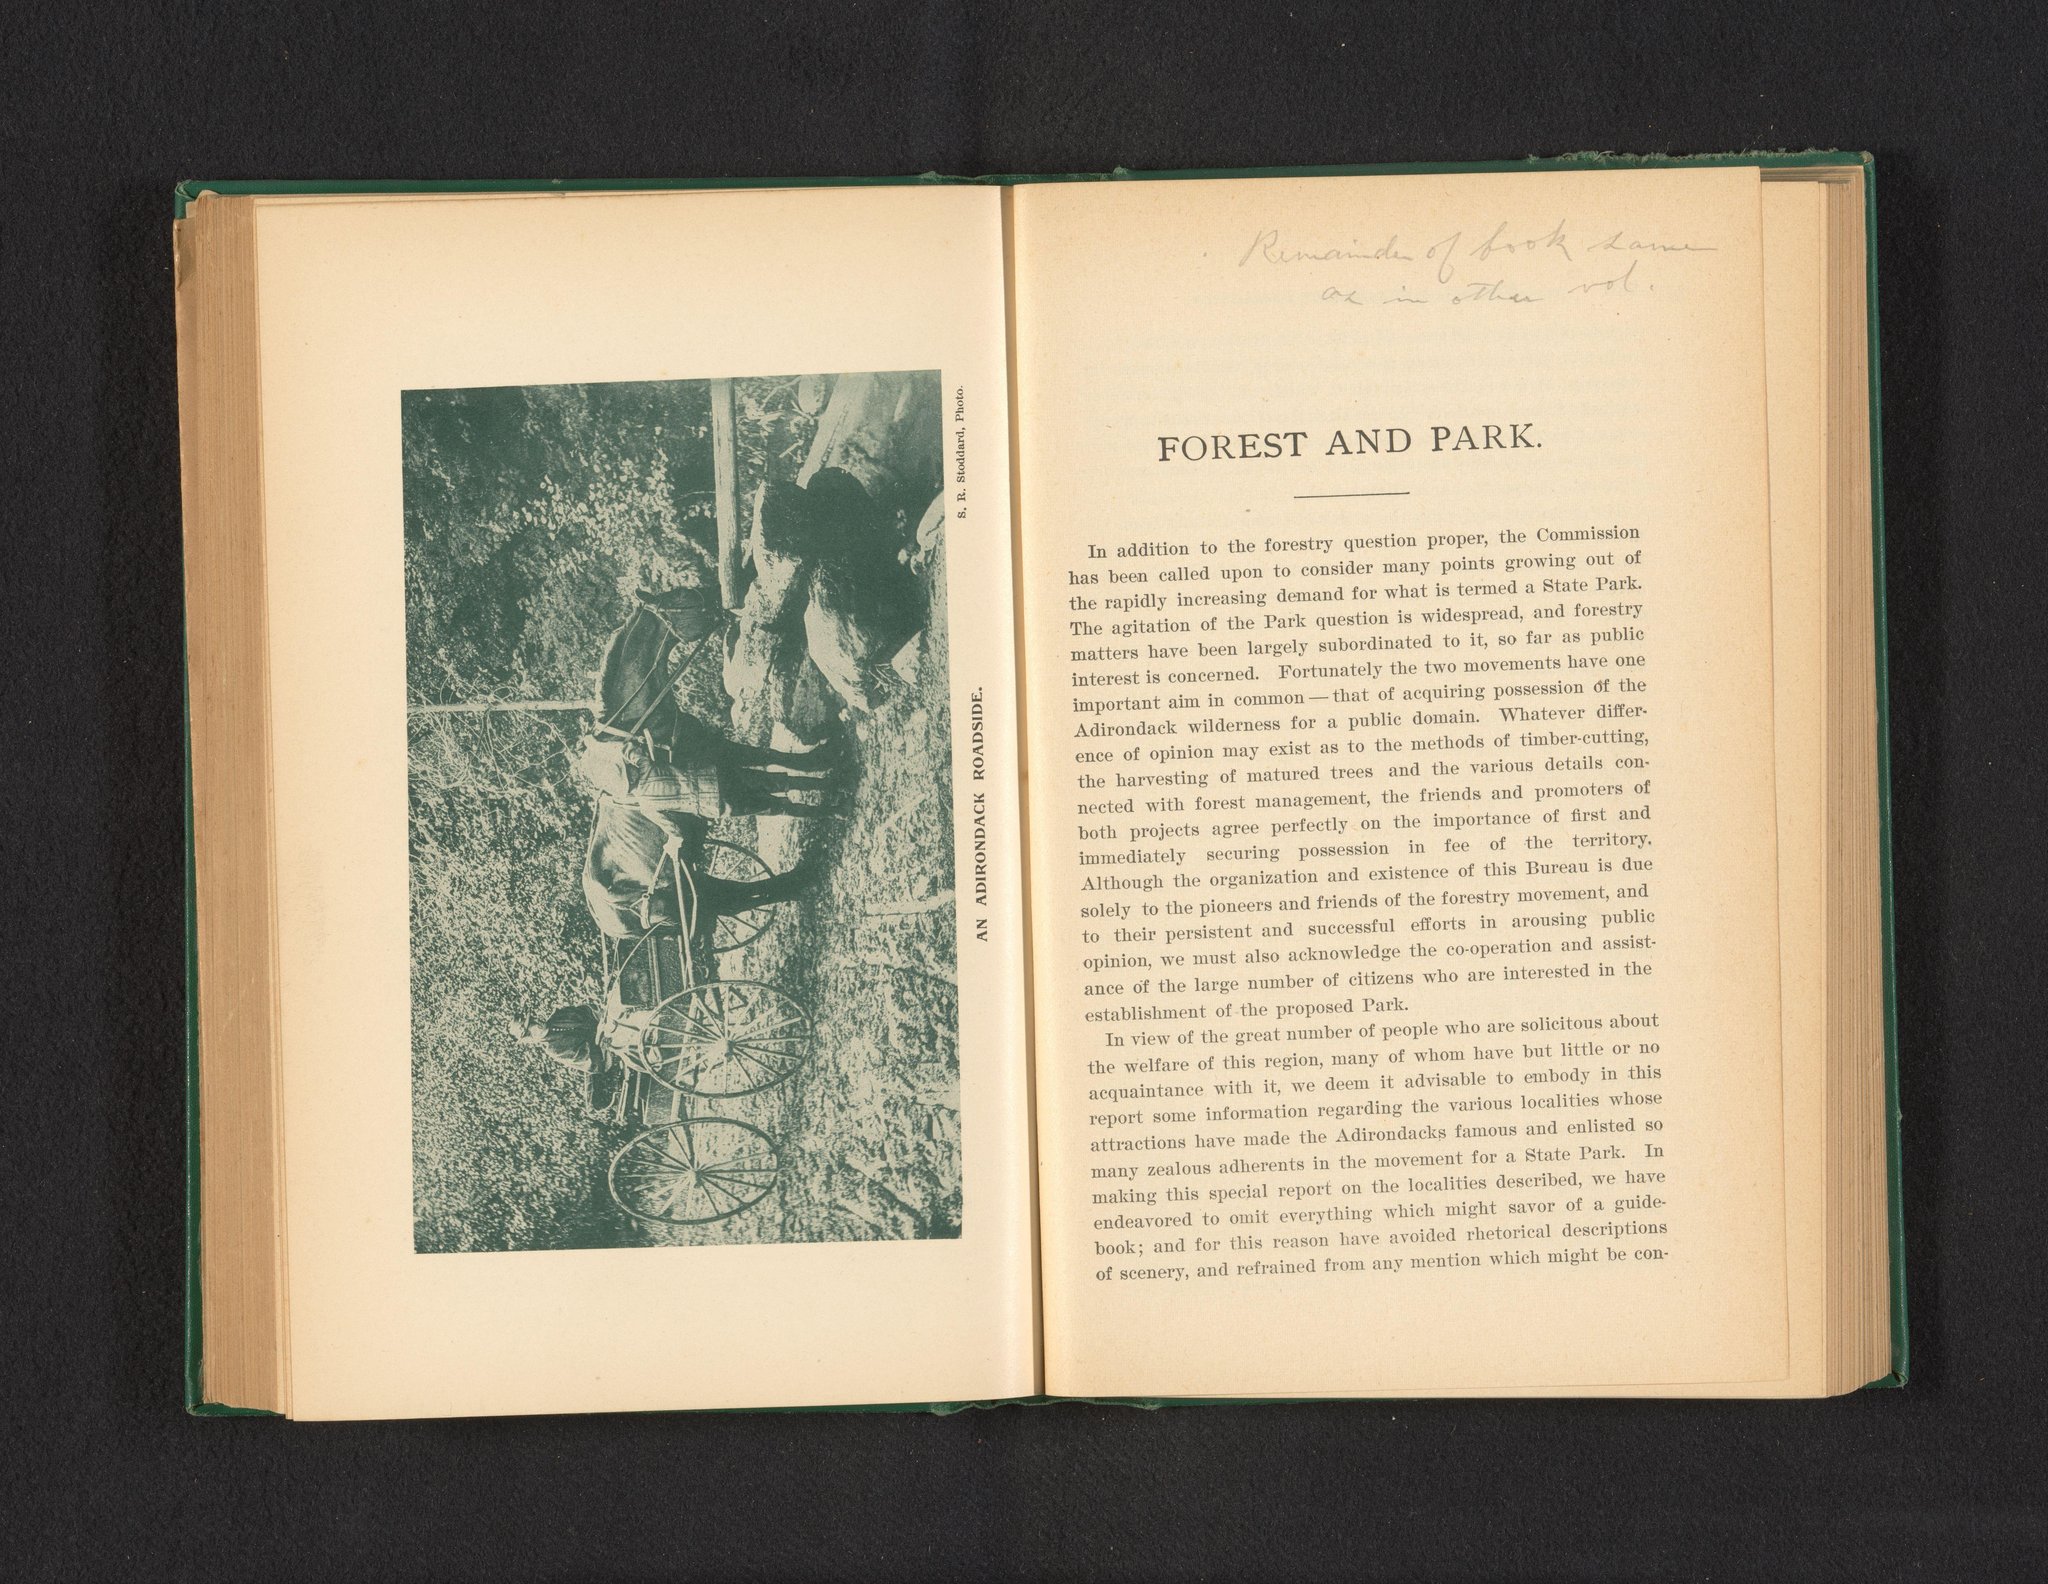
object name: photomechanical print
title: An Adirondack roadside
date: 1893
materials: paper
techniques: photograph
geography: adirondack mountains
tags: four-wheeled, animal-drawn vehicle, e.g.: cab, carriage, coach